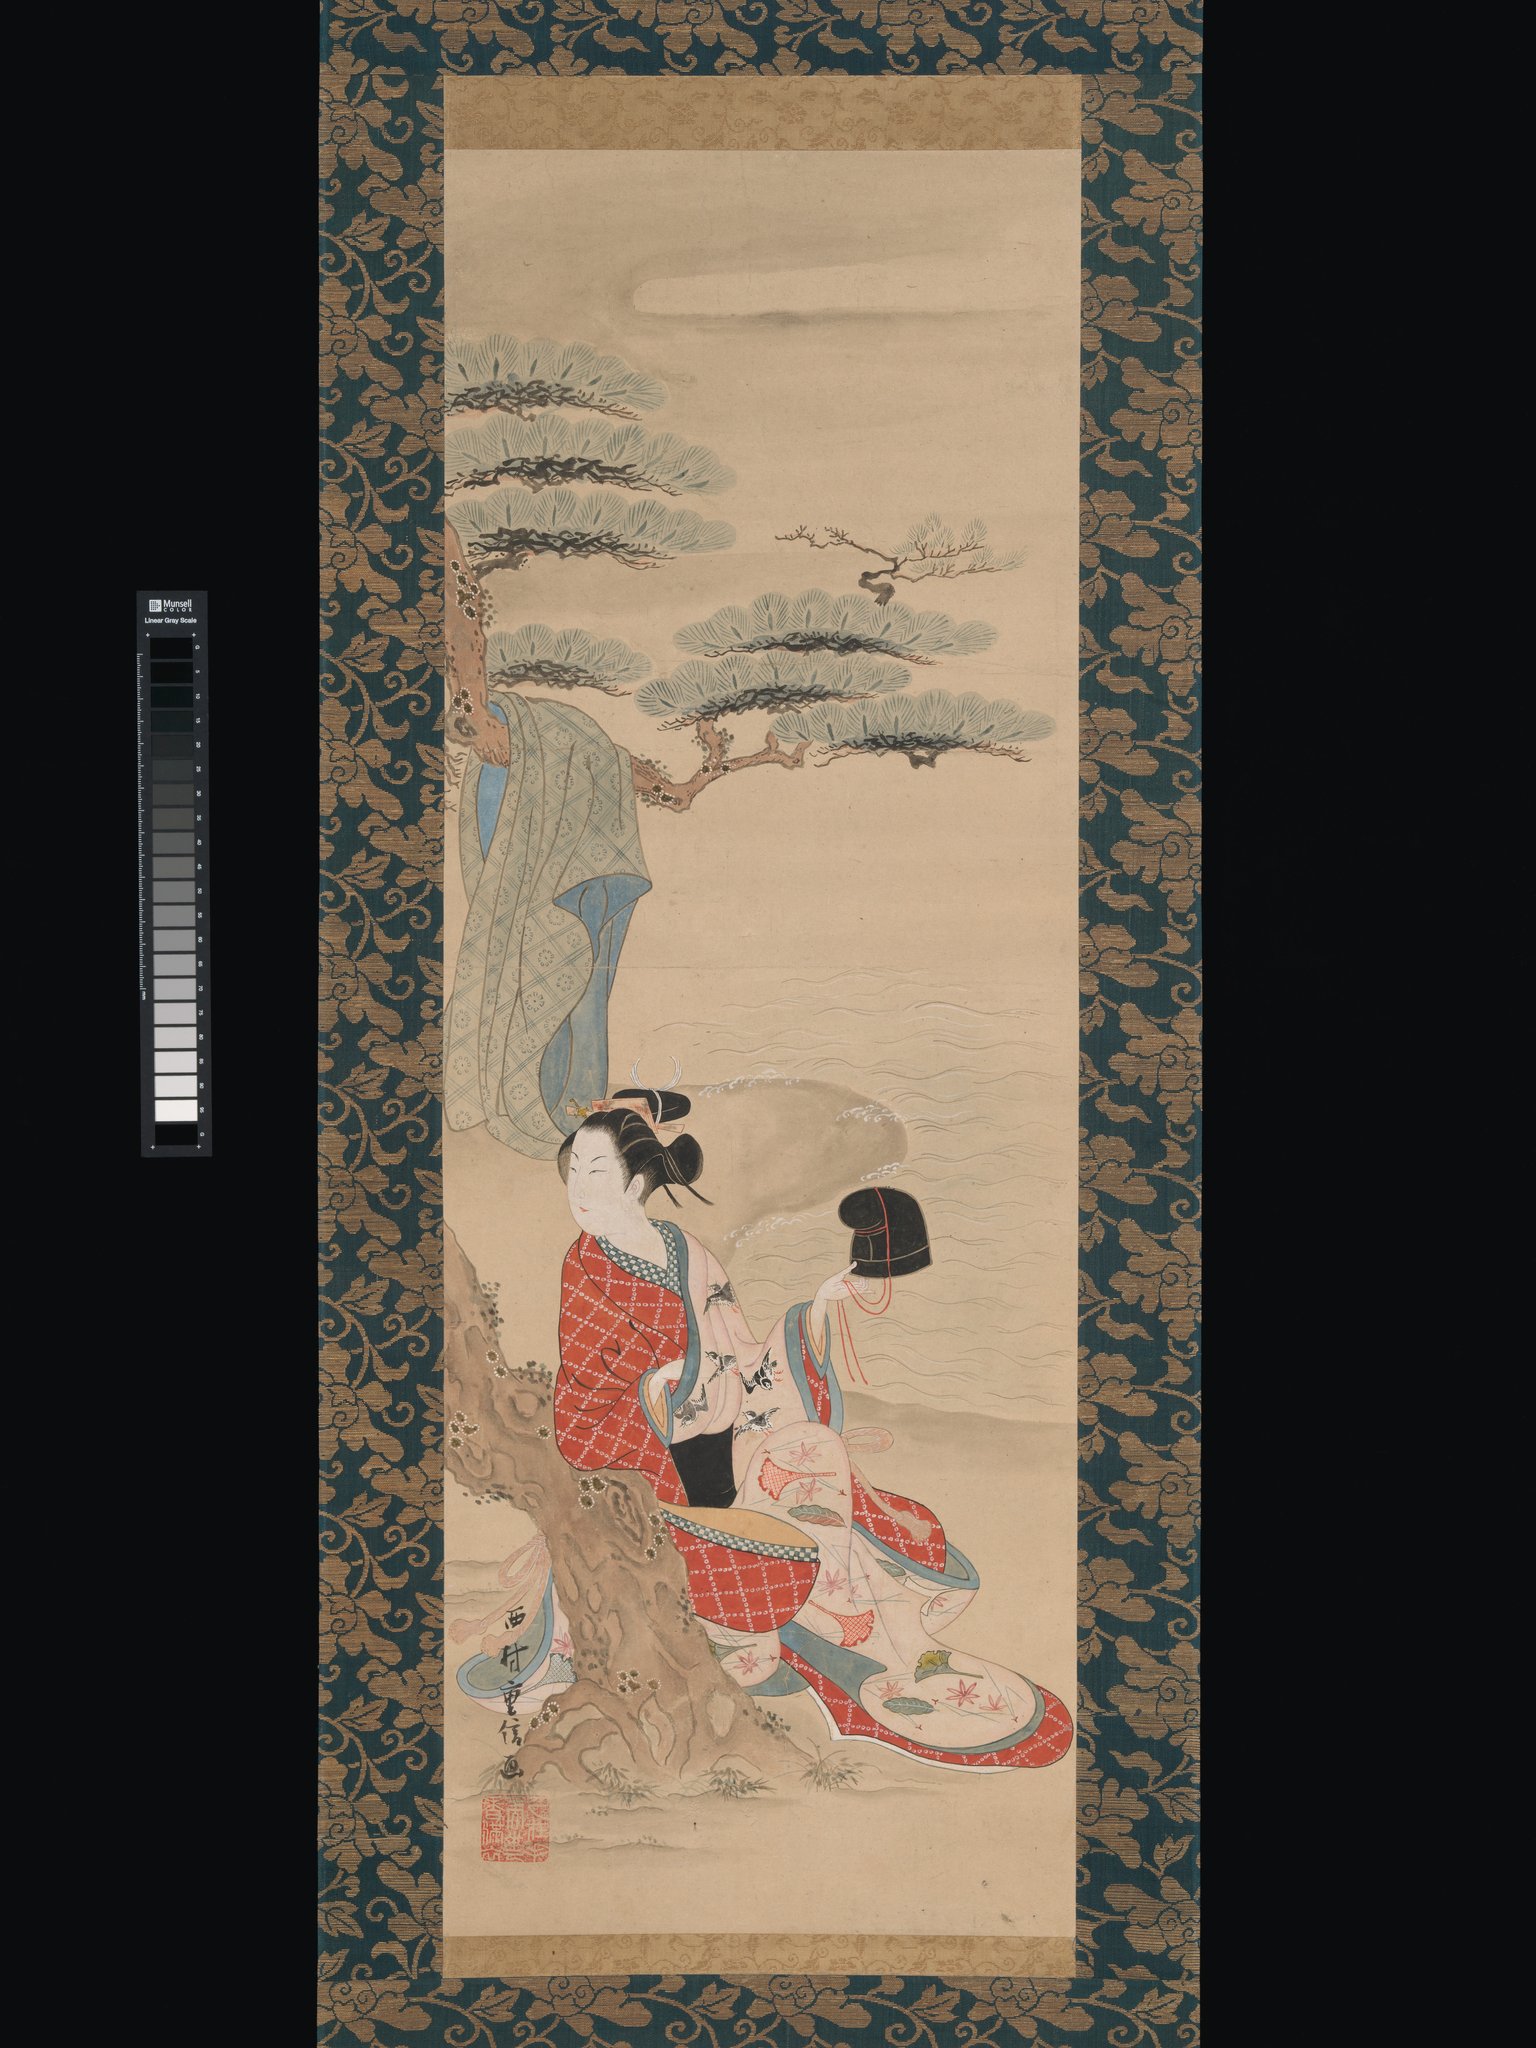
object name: hanging scroll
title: The Brine Maiden Matsukaze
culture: japanese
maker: nishimura shigenobu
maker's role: artist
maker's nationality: japanese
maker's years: 1729-1739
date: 1701-1733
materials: ink, paper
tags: women